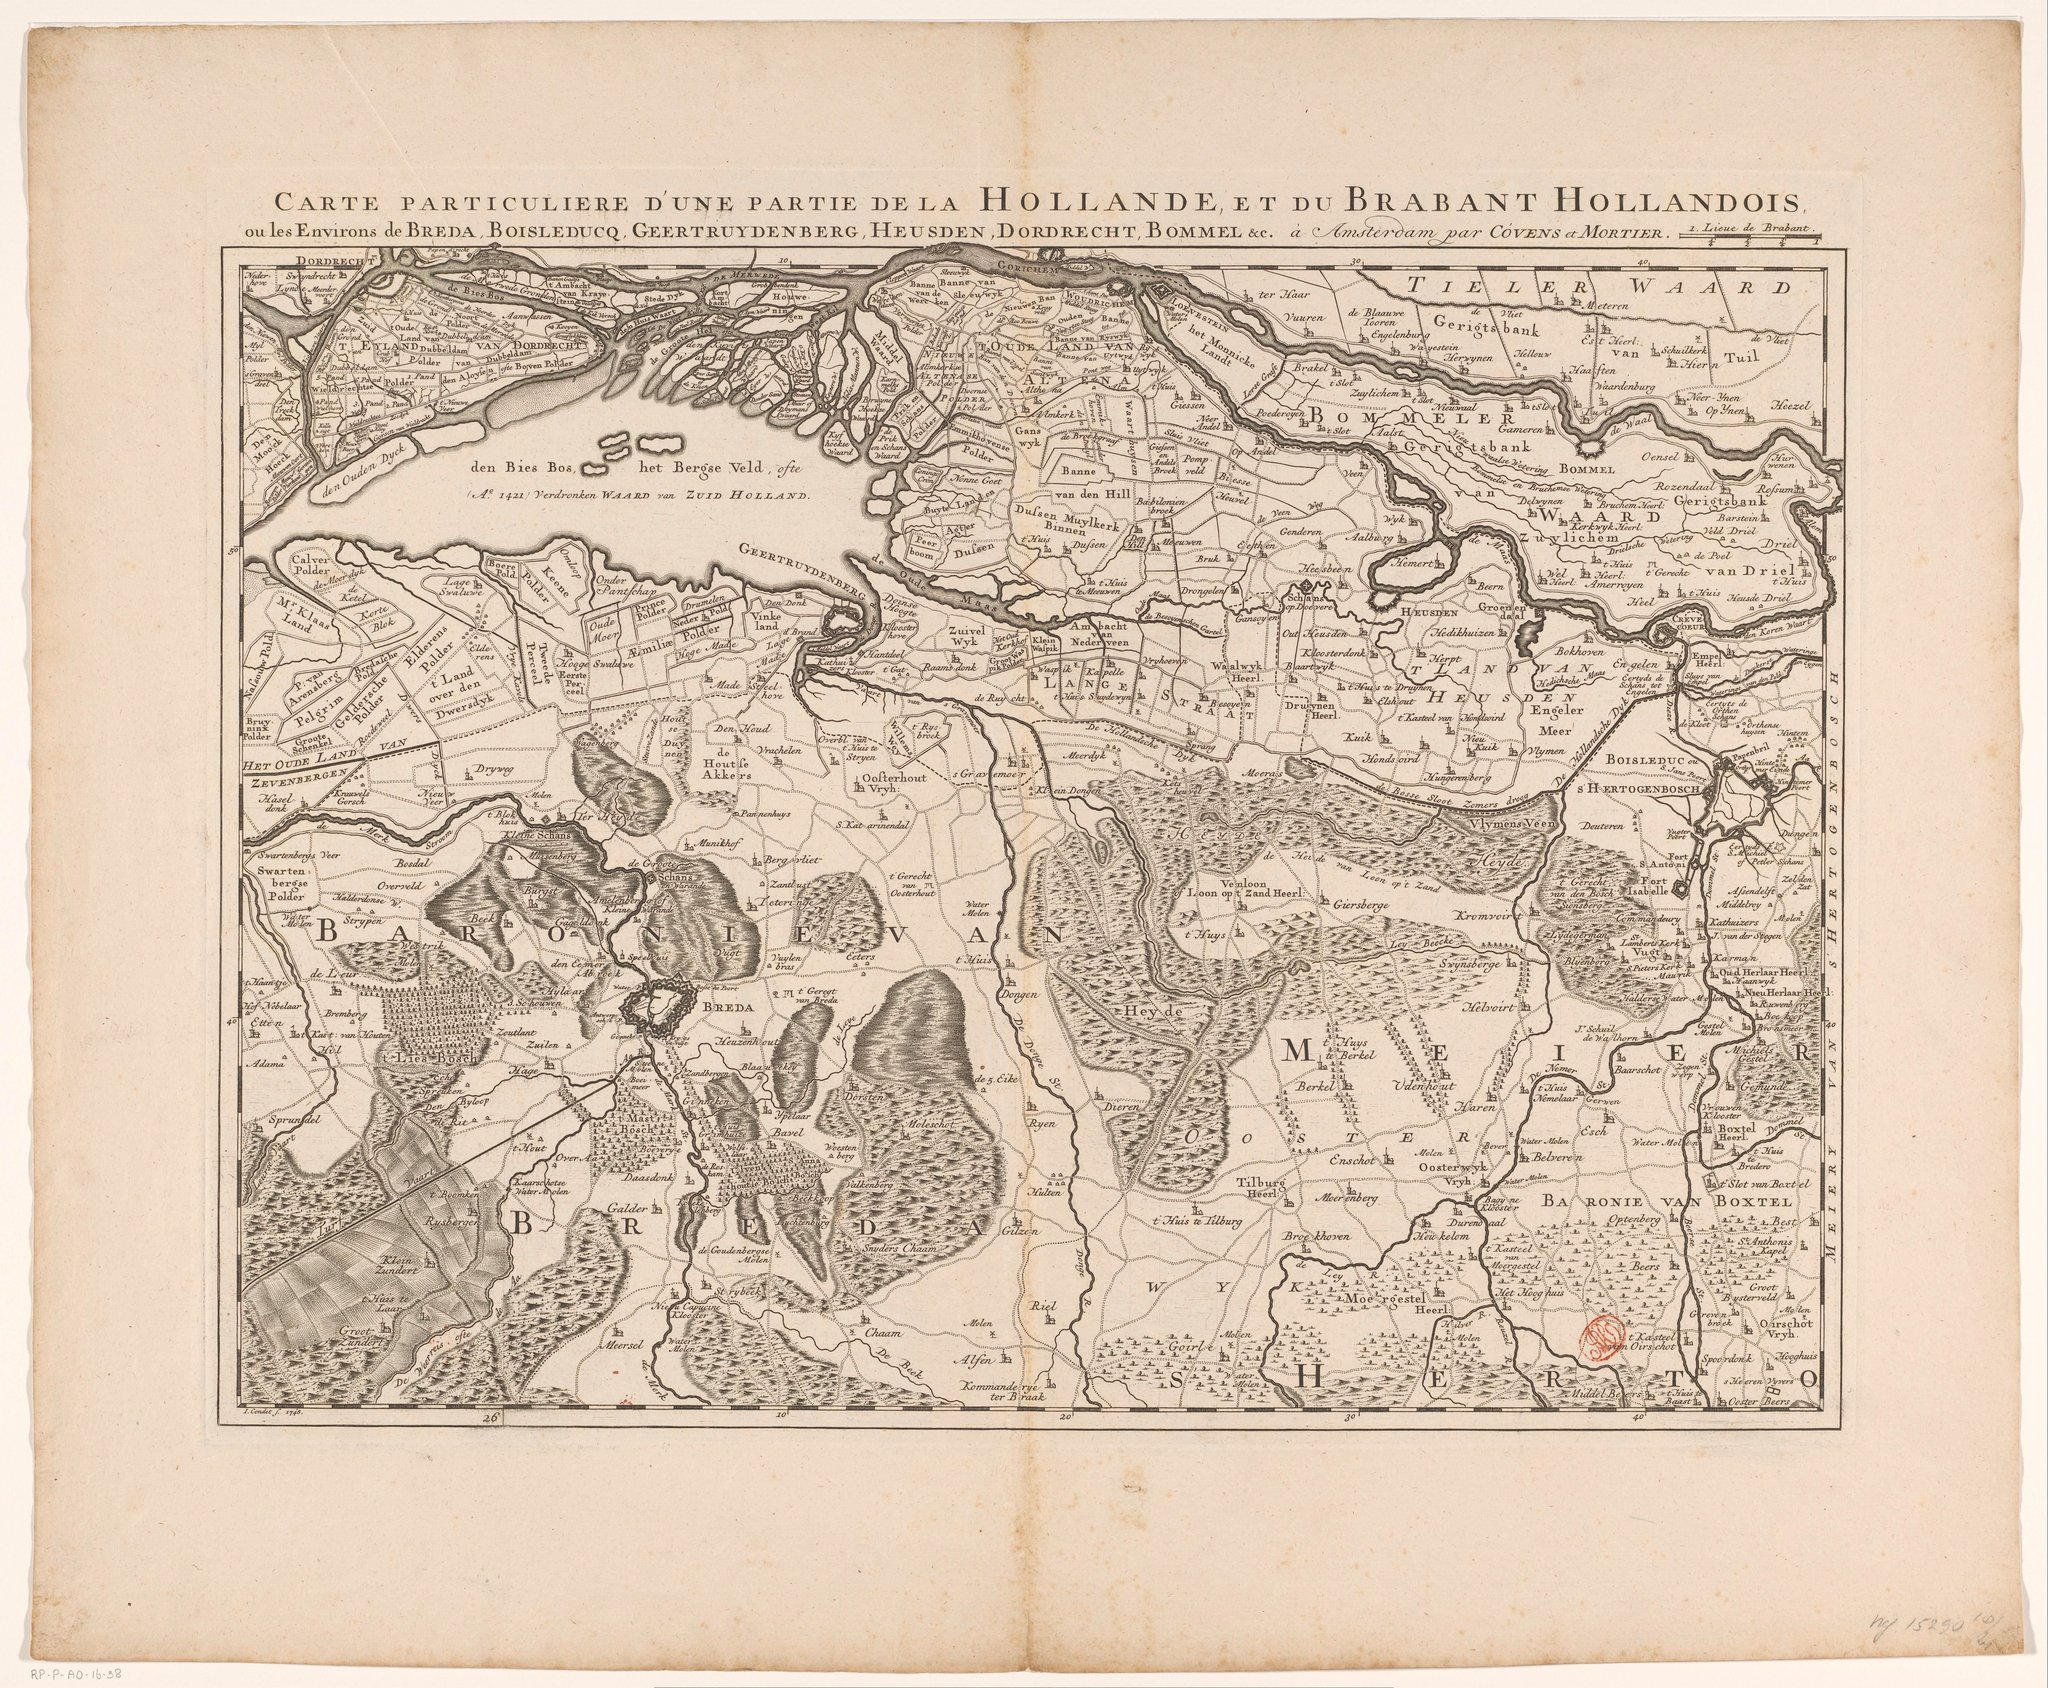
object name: map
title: Carte particuliere d'une partie de la Hollande, et du Brabant Hollandois (...)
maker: johannes condet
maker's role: print maker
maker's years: 1711-1781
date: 1748-1774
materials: paper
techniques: engraving, etching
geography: amsterdam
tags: maps of separate countries or regions, den bosch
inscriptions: collector's mark: Lugt 195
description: Kaart van het noordwestelijk deel van Brabant. Boven de kaart de titel en een schaalstok: 1 Lieue de Brabant. Langs de randen van de prent een gradenverdeling.